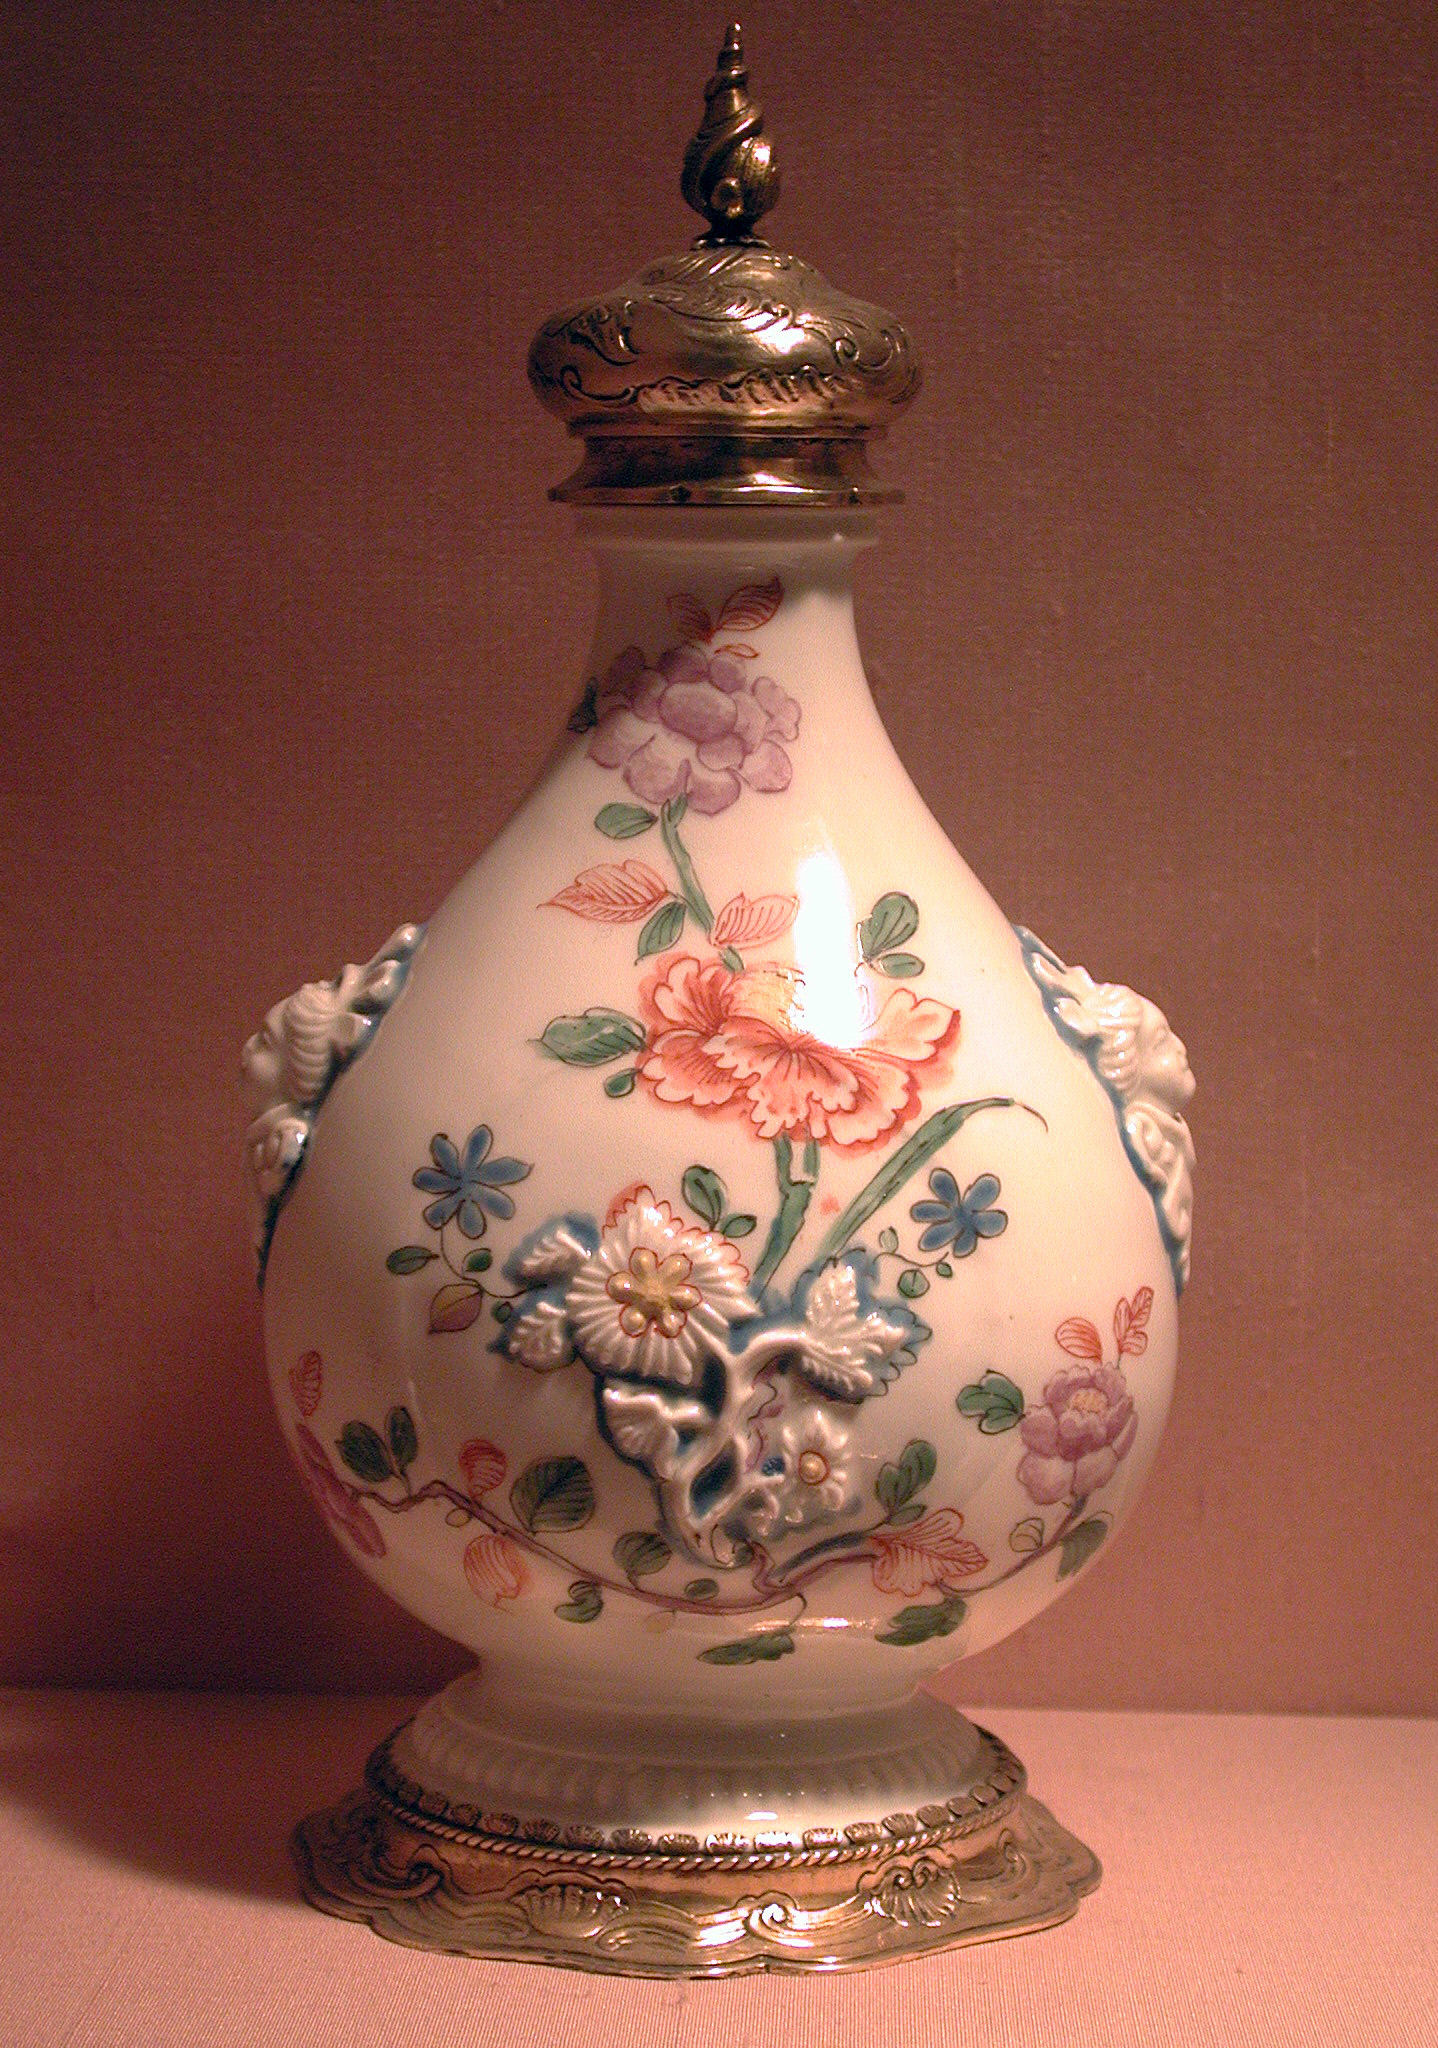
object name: pilgrim bottle with cover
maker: vienna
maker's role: manufactory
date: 1725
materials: hard paste porcelain, silver gilt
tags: flowers